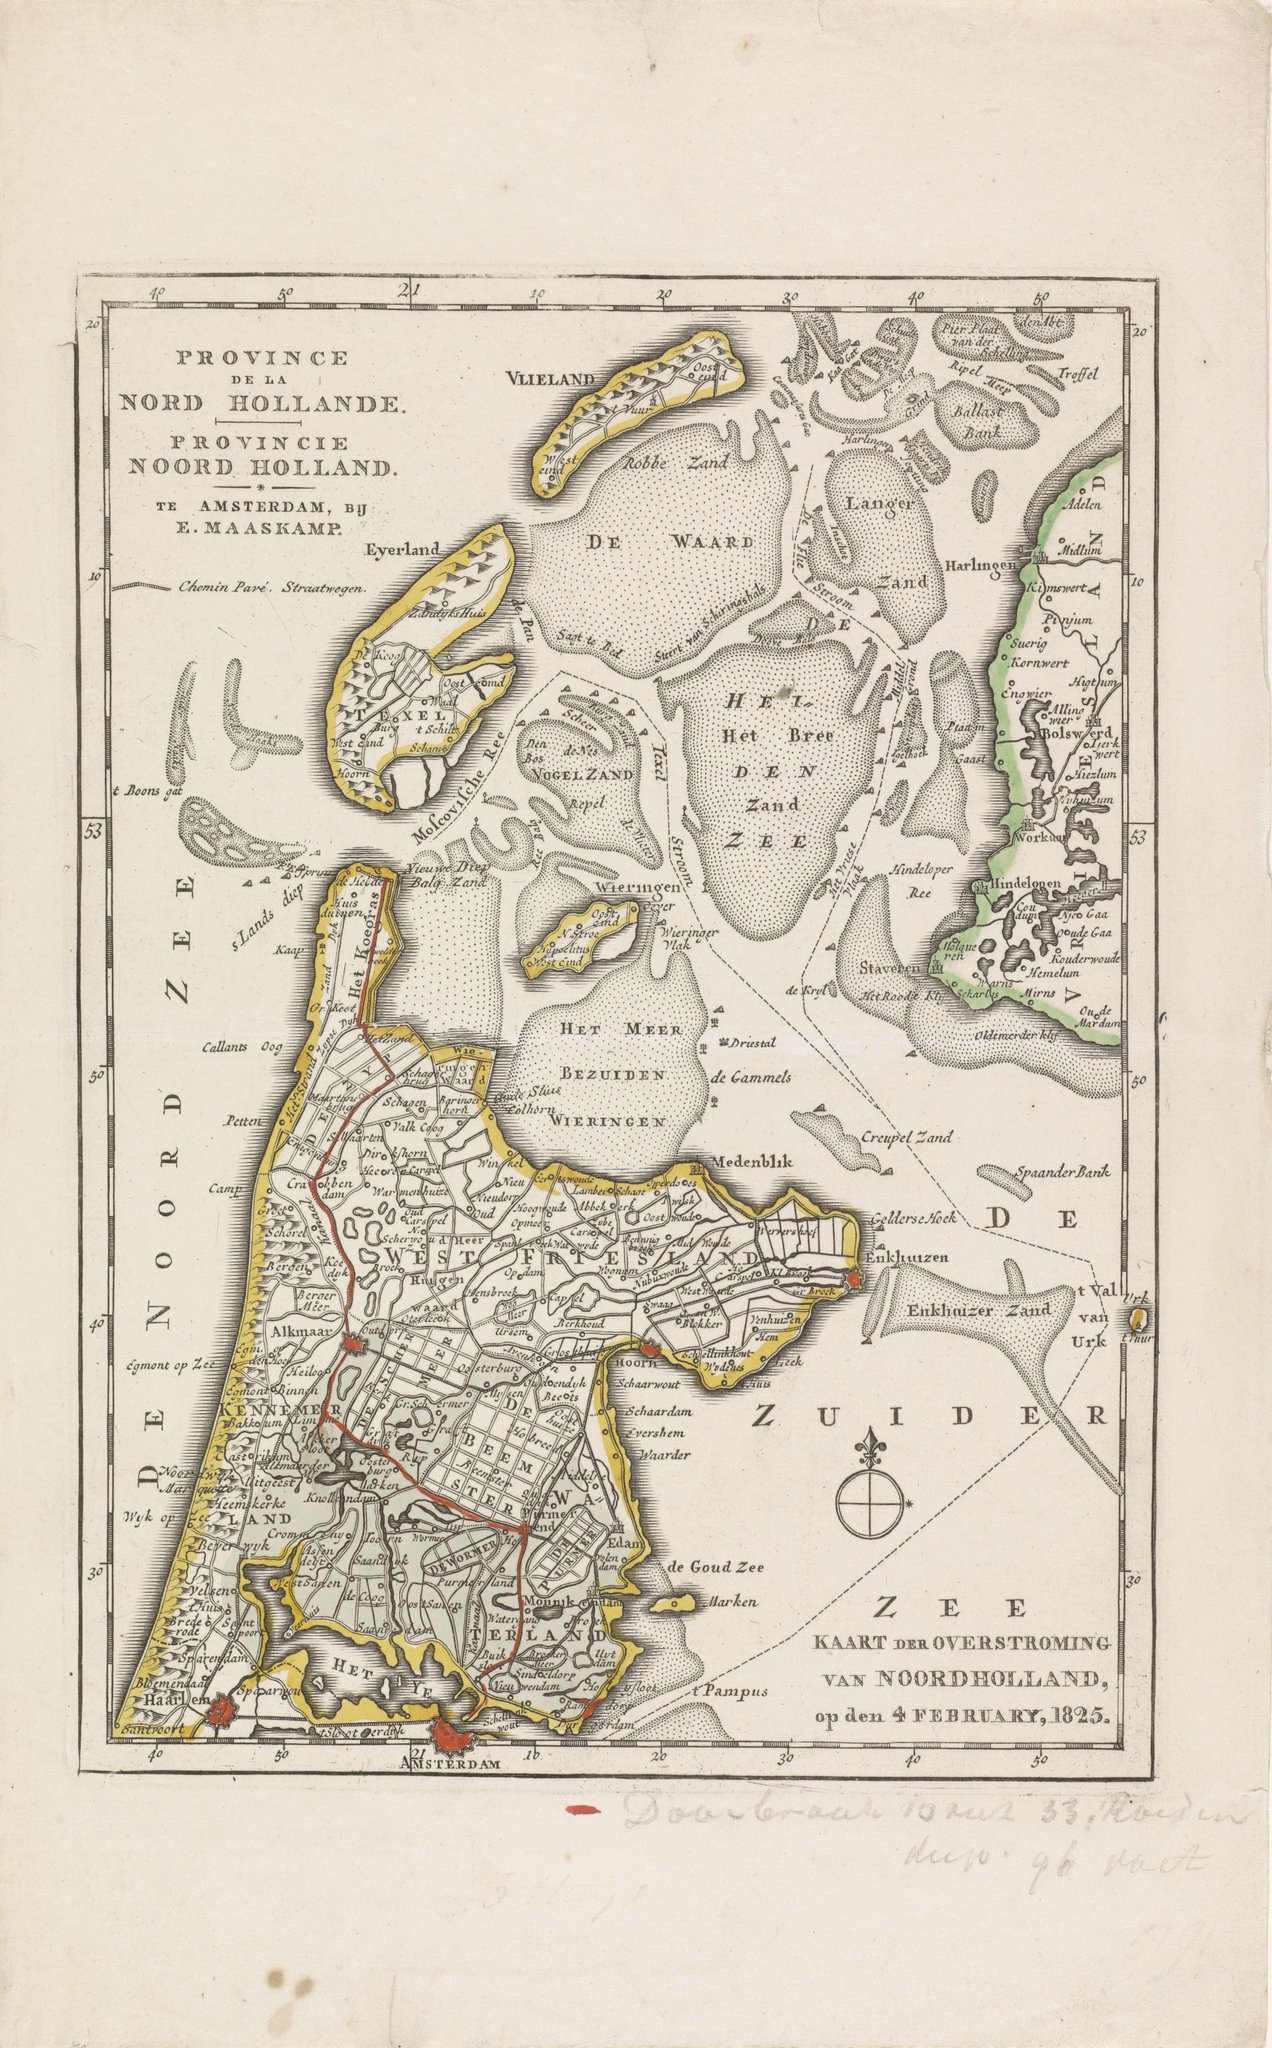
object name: map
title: Kaart van het gebied in Noord-Holland getroffen door de overstromingen in 1825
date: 1825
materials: paper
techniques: engraving, hand coloring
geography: netherlands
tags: maps of separate countries or regions, flood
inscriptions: collector's mark: Lugt 2228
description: Kaart van de provincie Noord-Holland, waarop het gebied getroffen door de overstromingen in februari 1825 met blauw is aangegeven. Met rood is een doorgebroken dijk gemarkeerd. Onderaan op het blad twee regels handschrift. Onderdeel van een serie van vijf kaarten van de getroffen gebieden.